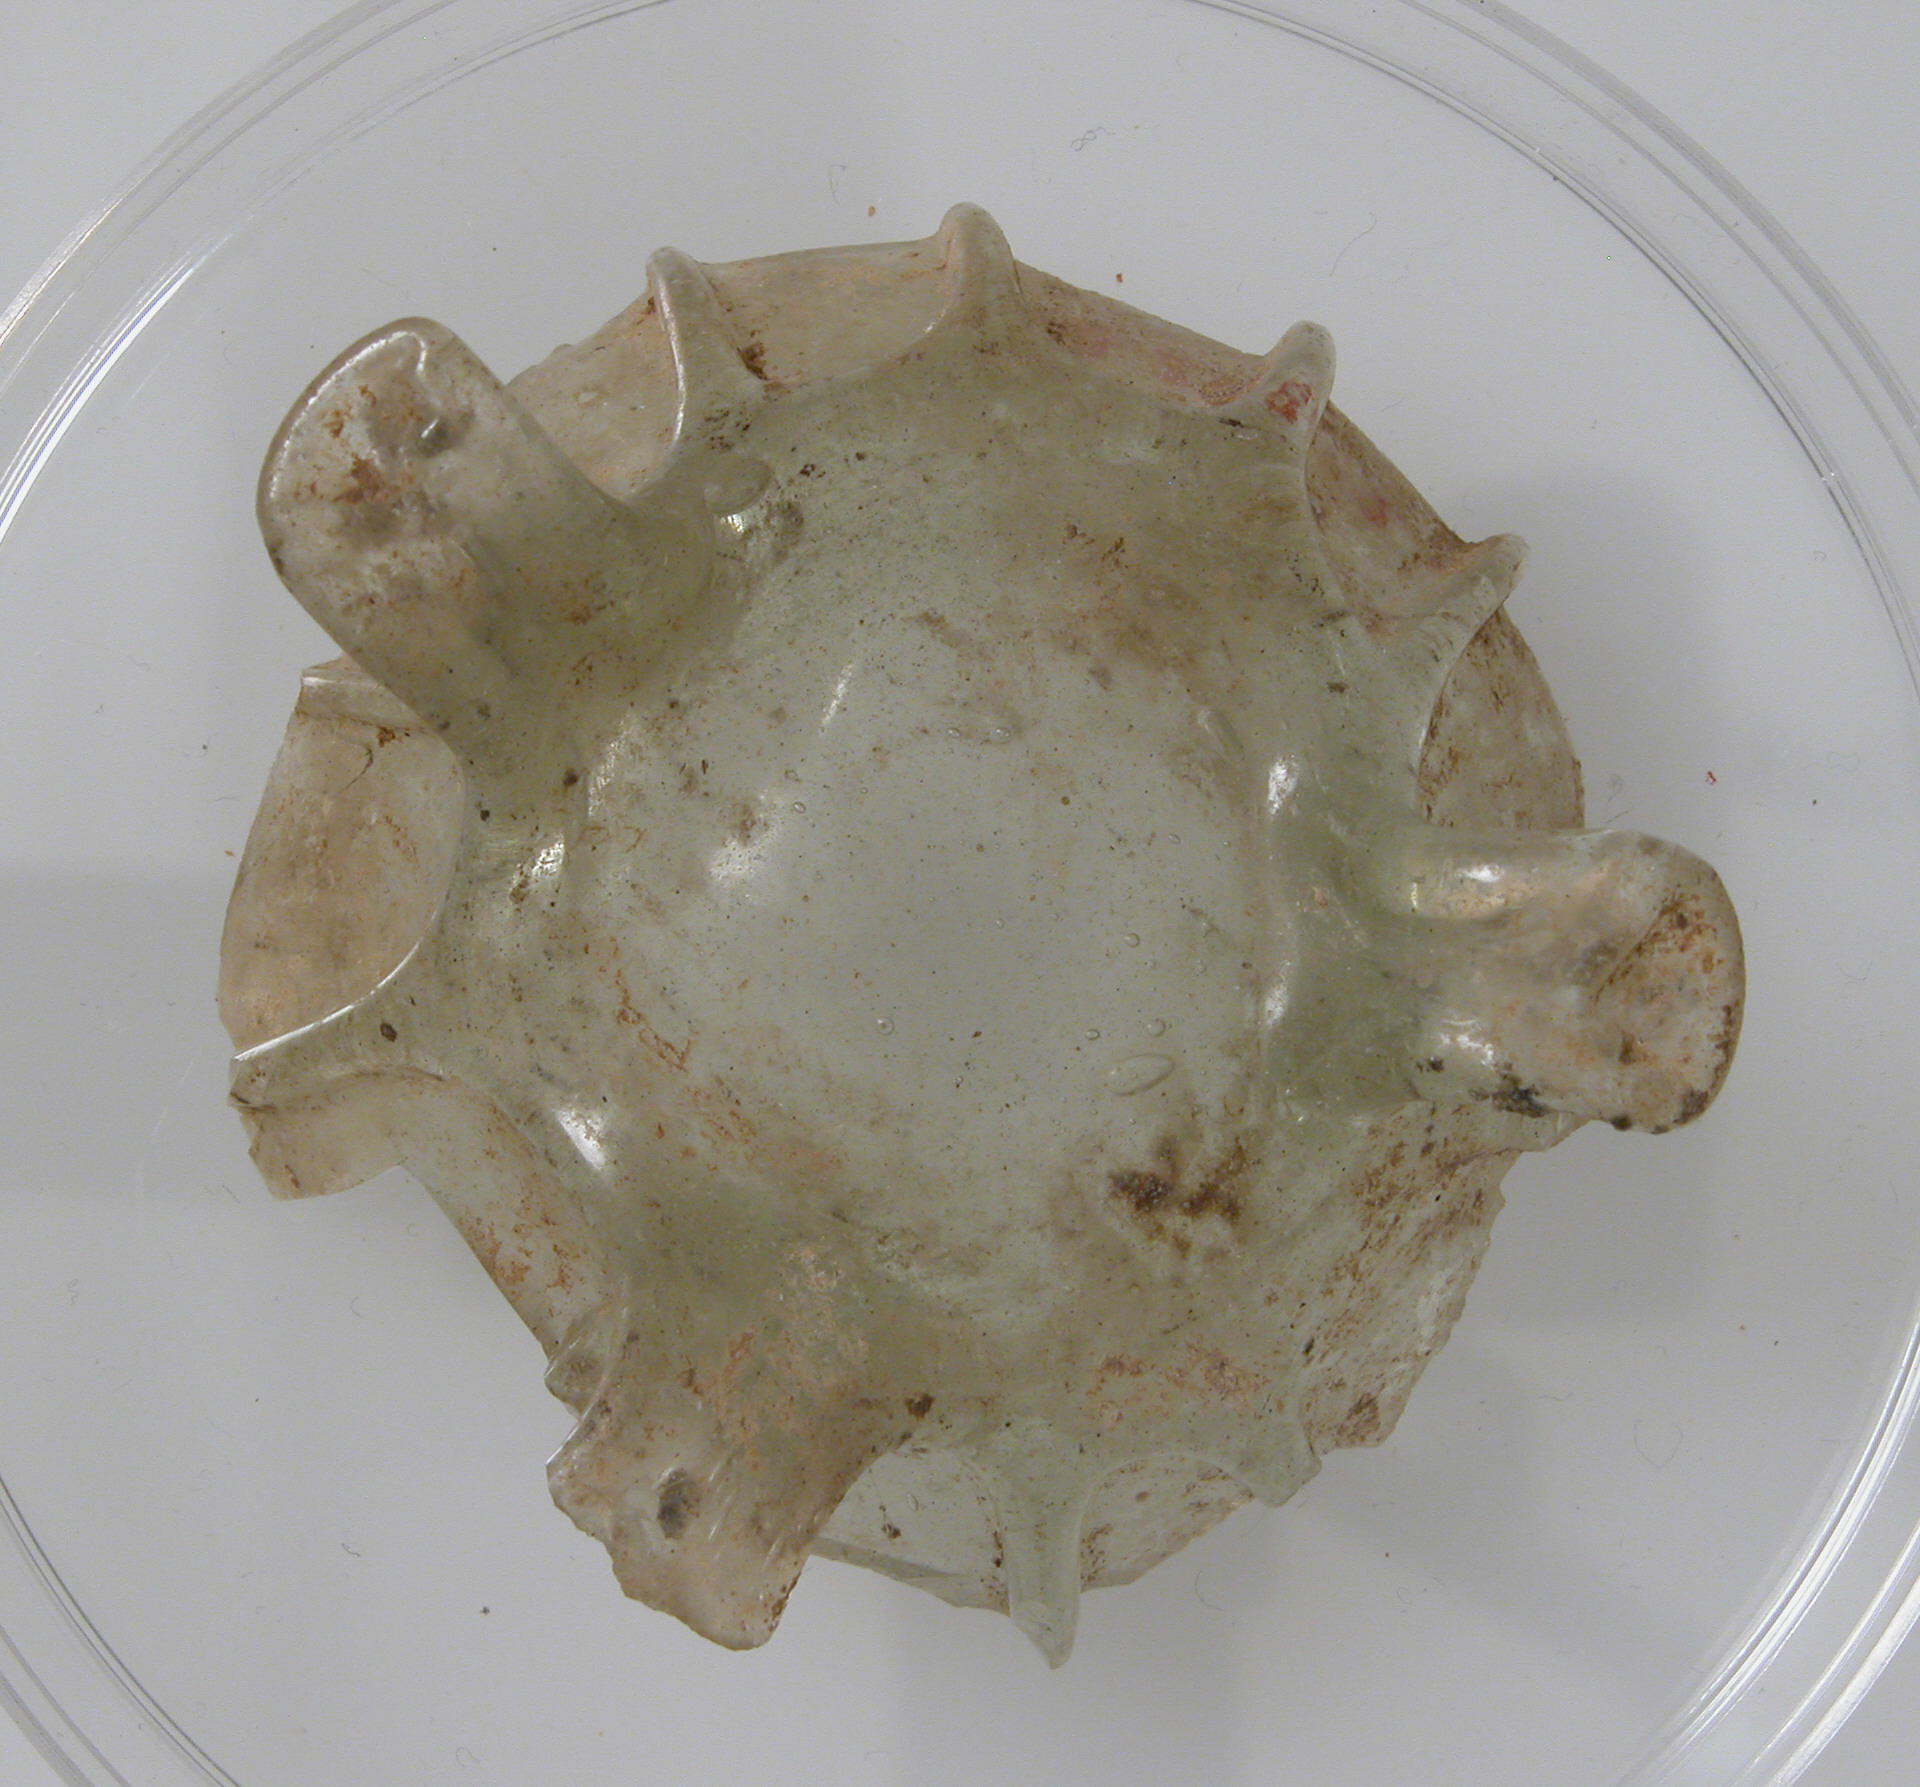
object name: fragment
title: Foot of a Vessel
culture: coptic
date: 301-433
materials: glass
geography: egypt